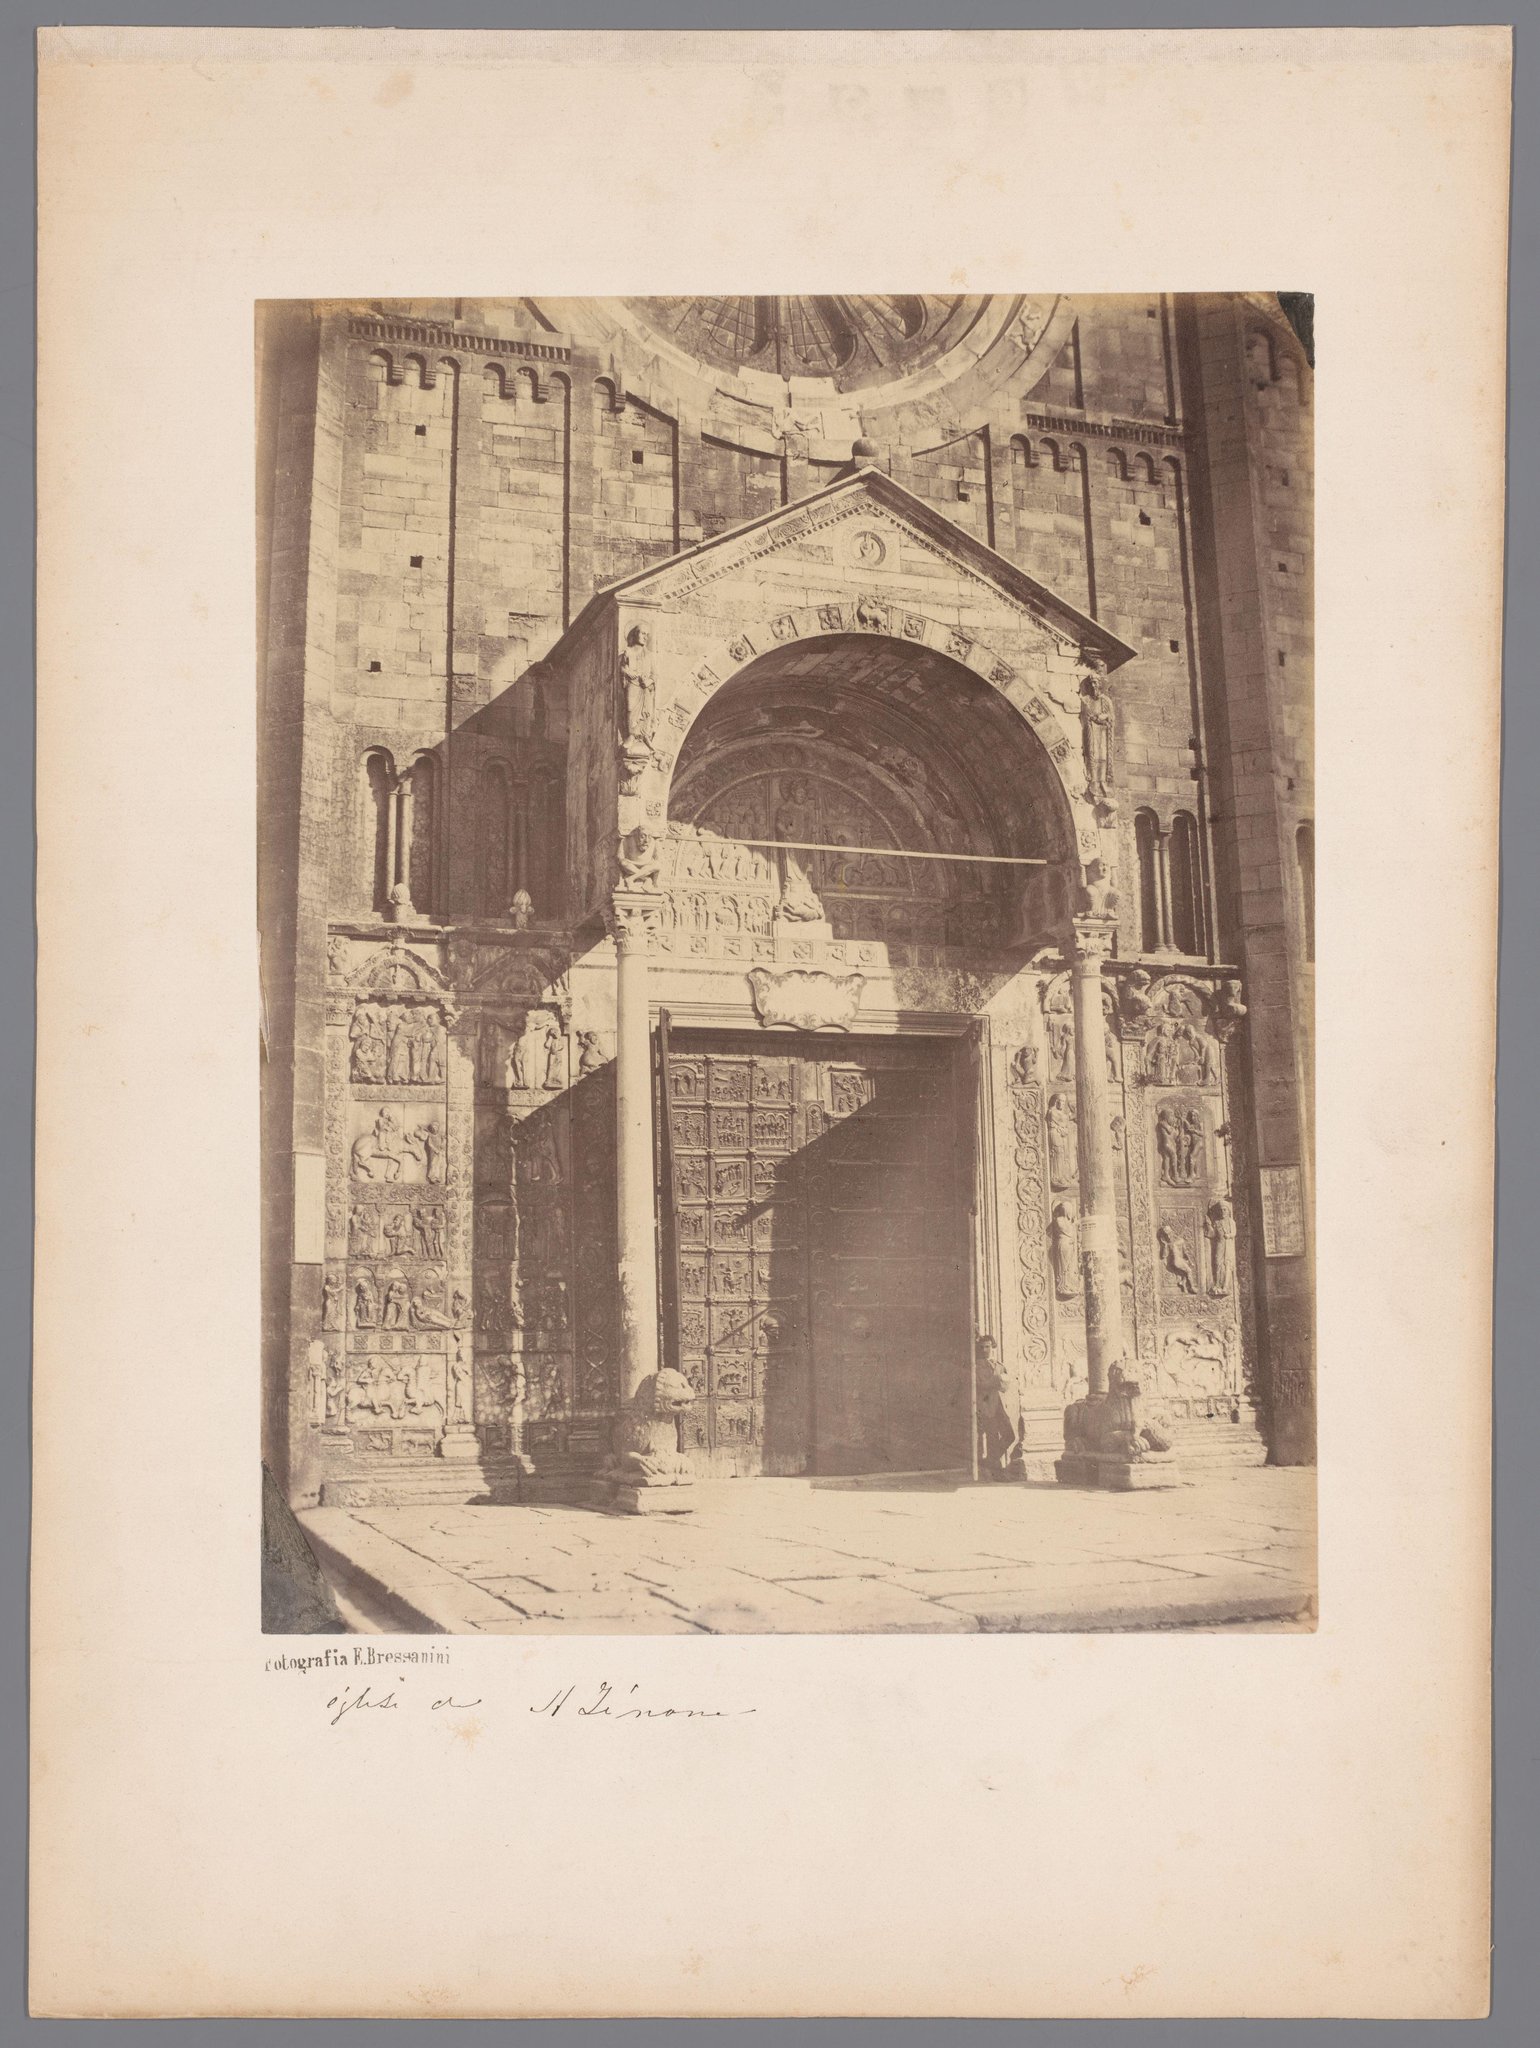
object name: photograph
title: Portaal van de Basilica di San Zeno (ook: San Zeno Maggiore), Verona, Italië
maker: emilio bressanini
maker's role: fotograaf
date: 1865-1880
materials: cardboard, paper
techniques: albumen print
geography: verona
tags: s. zeno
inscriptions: caption: ‘ogliti di St. Zinone [?]’, number: ‘1183.’, date: ‘1860's’, stamp: ‘Fotografia E. Bressanini’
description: Portaal van de Basilica di San Zeno (ook: San Zeno Maggiore), Verona, Italië.